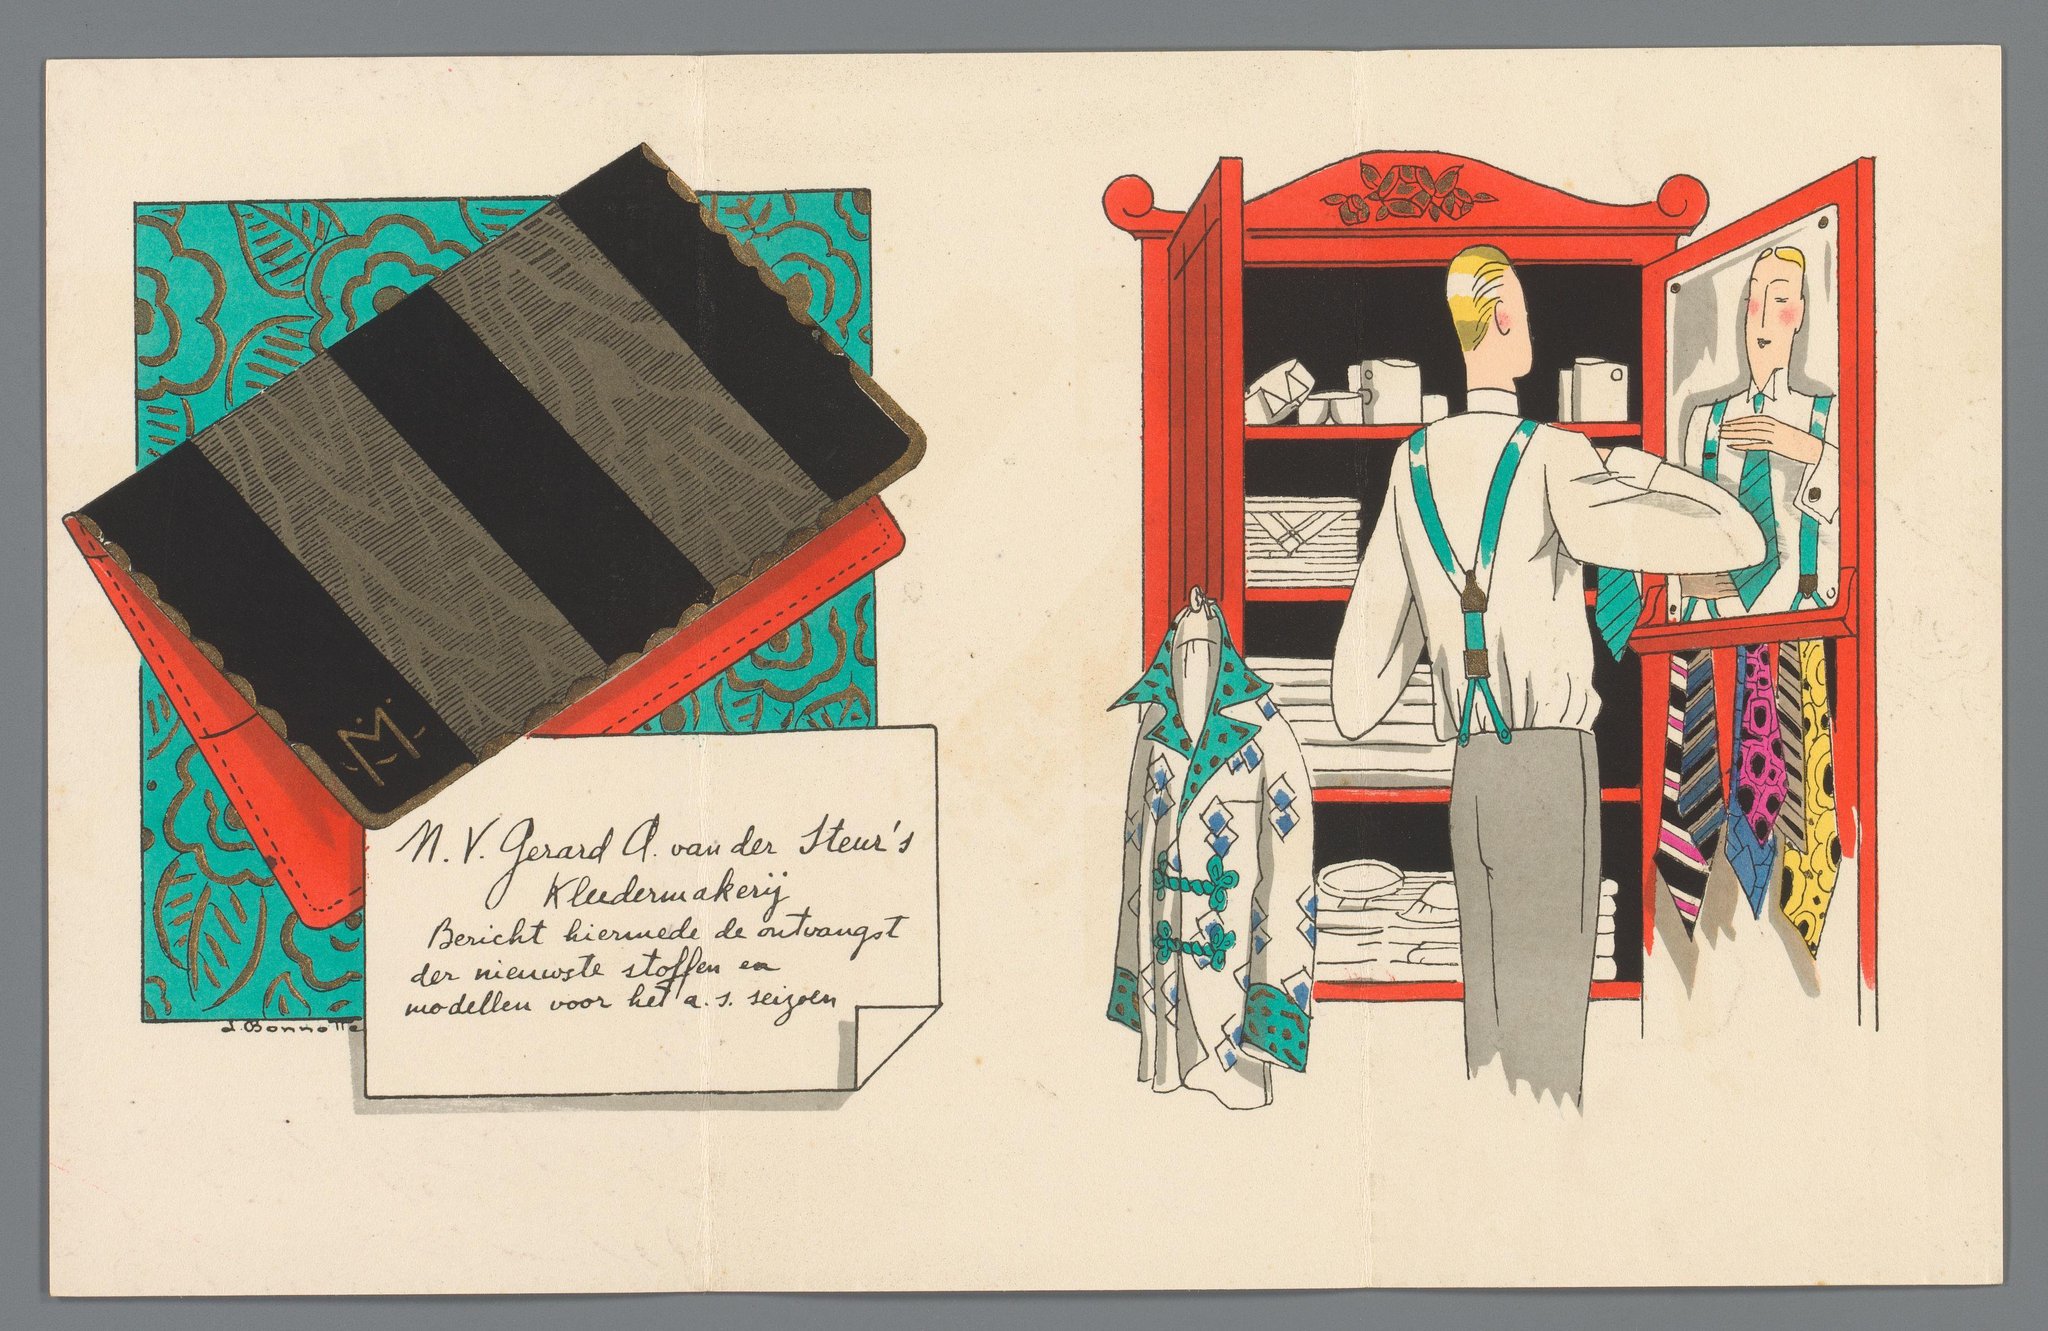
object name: print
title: Reclamefolder voor N.V. Gerard A. van der Steur's Kleedingmakerij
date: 1905-1950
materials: paper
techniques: lithograph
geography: paris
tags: dandy, beau, brochure, fashion plates, dressing oneself, getting dressed, haarlem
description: Reclamefolder voor de kledingzaak van G.A. van der Steur aan de Kruisstraat te Haarlem. Gevouwen blad met op de voorzijde een heer in rokkostuum, binnenin tekst en een man die zich voor de kledingkast aankleedt.